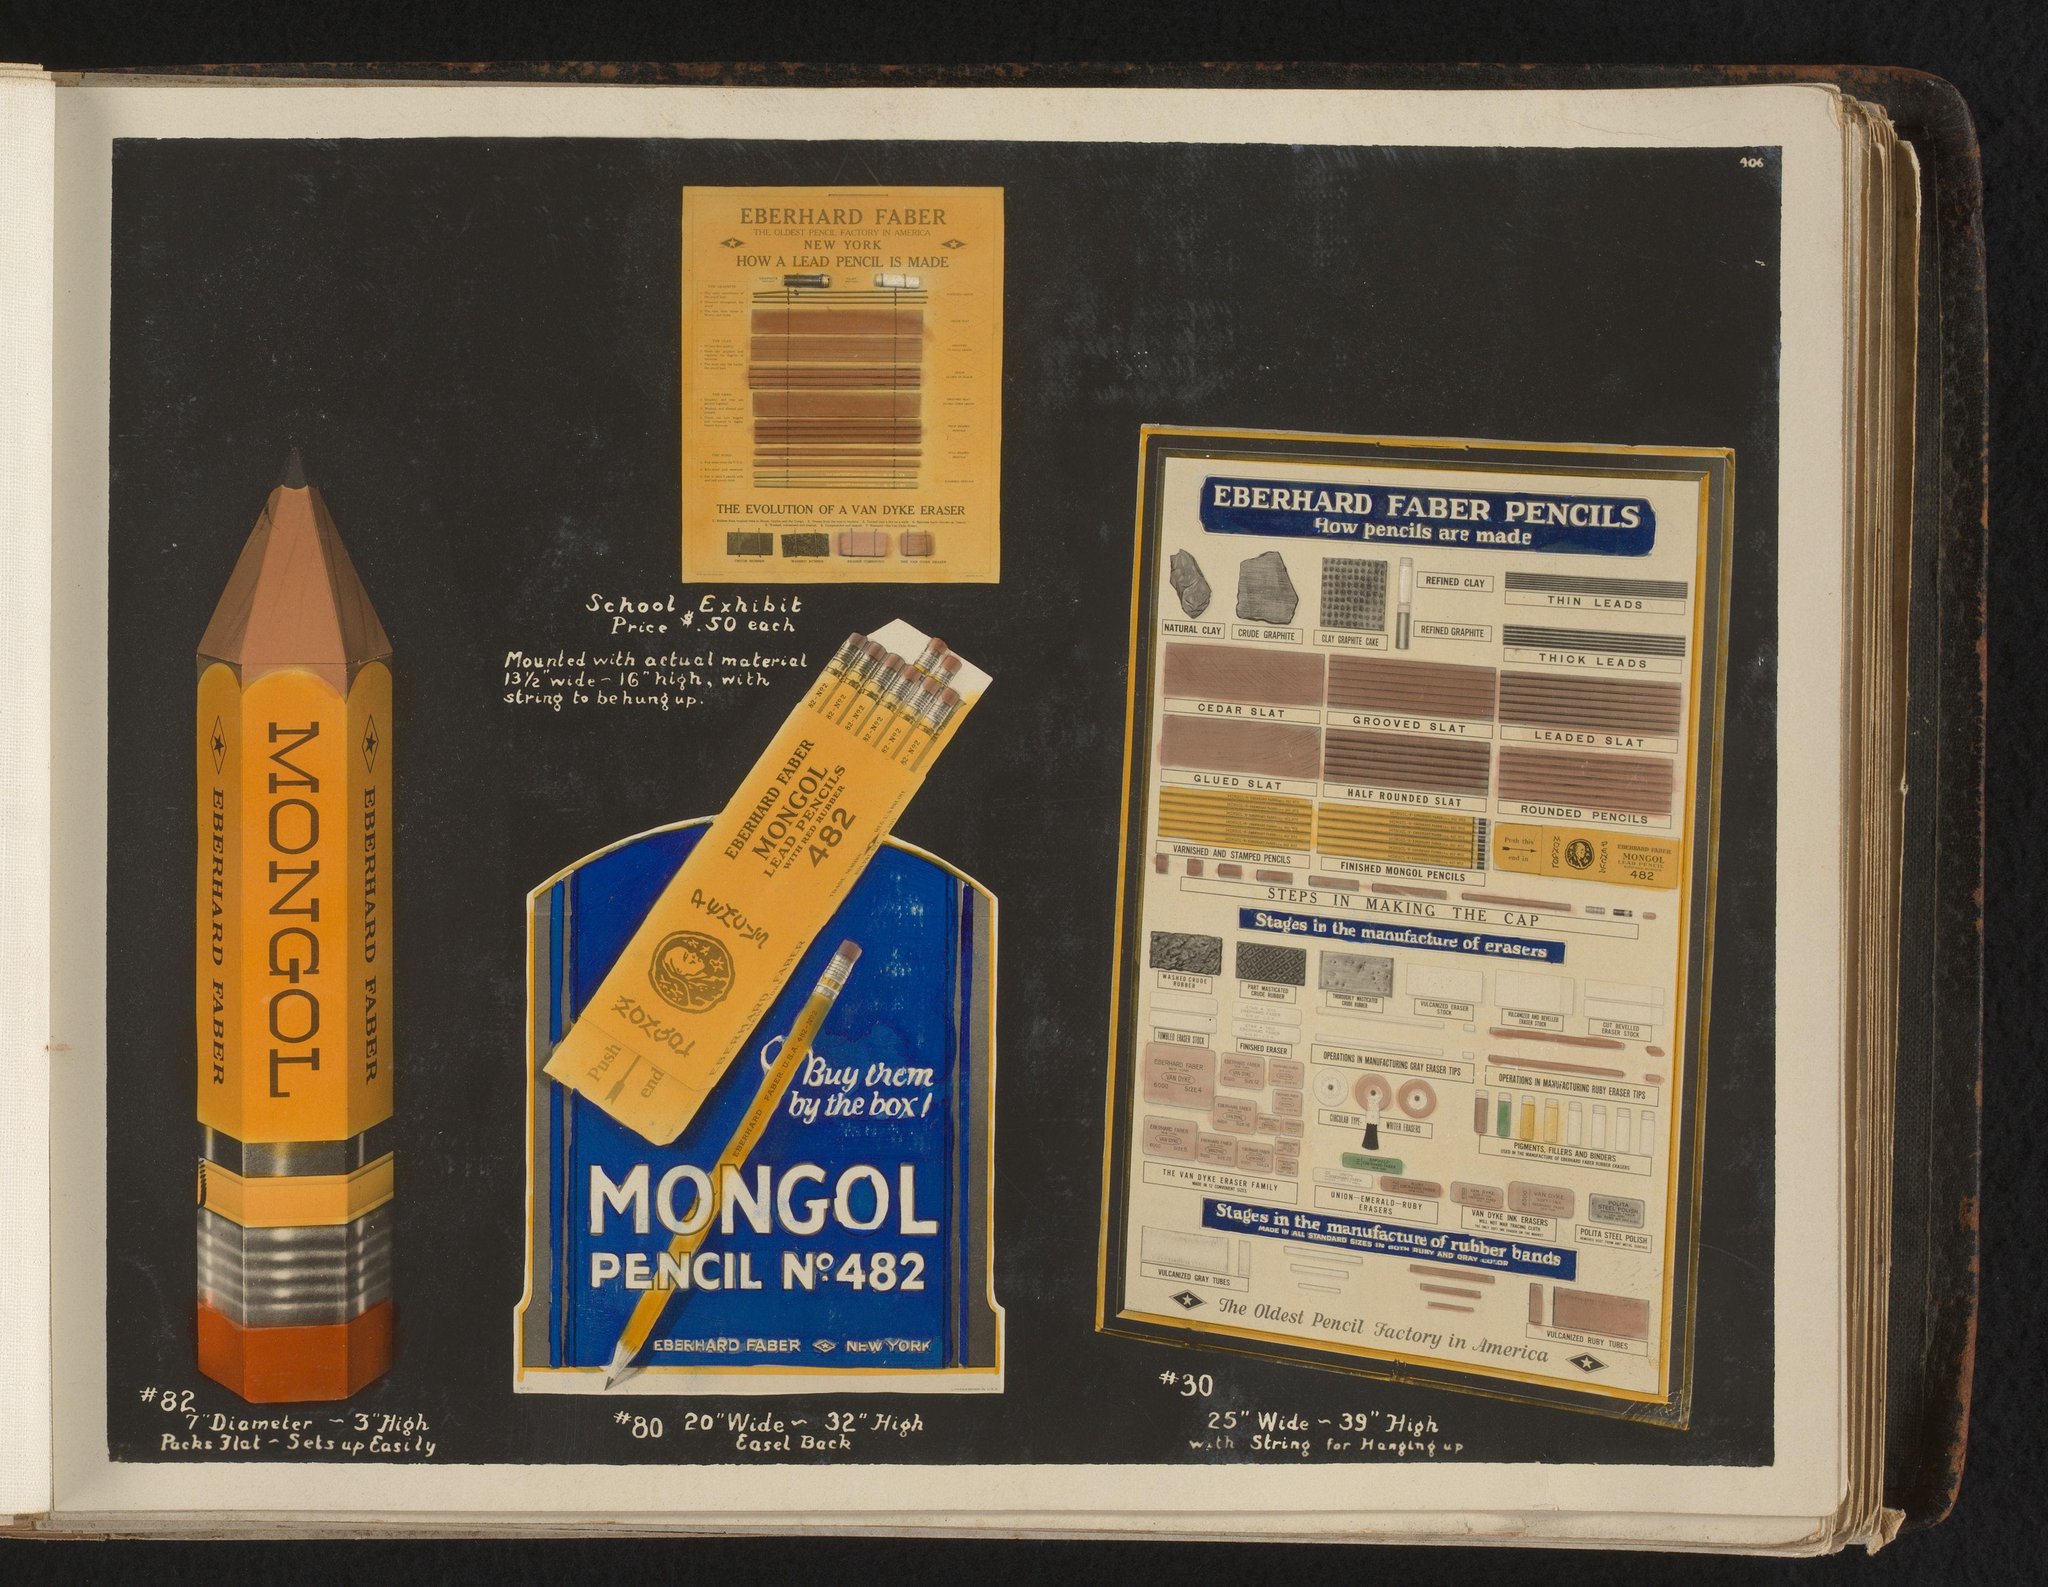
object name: album leaf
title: Reclamemateriaal voor potloden van Eberhard Faber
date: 1915-1935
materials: paper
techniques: gelatin silver print, hand coloring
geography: springfield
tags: pencil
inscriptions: number: ‘406’